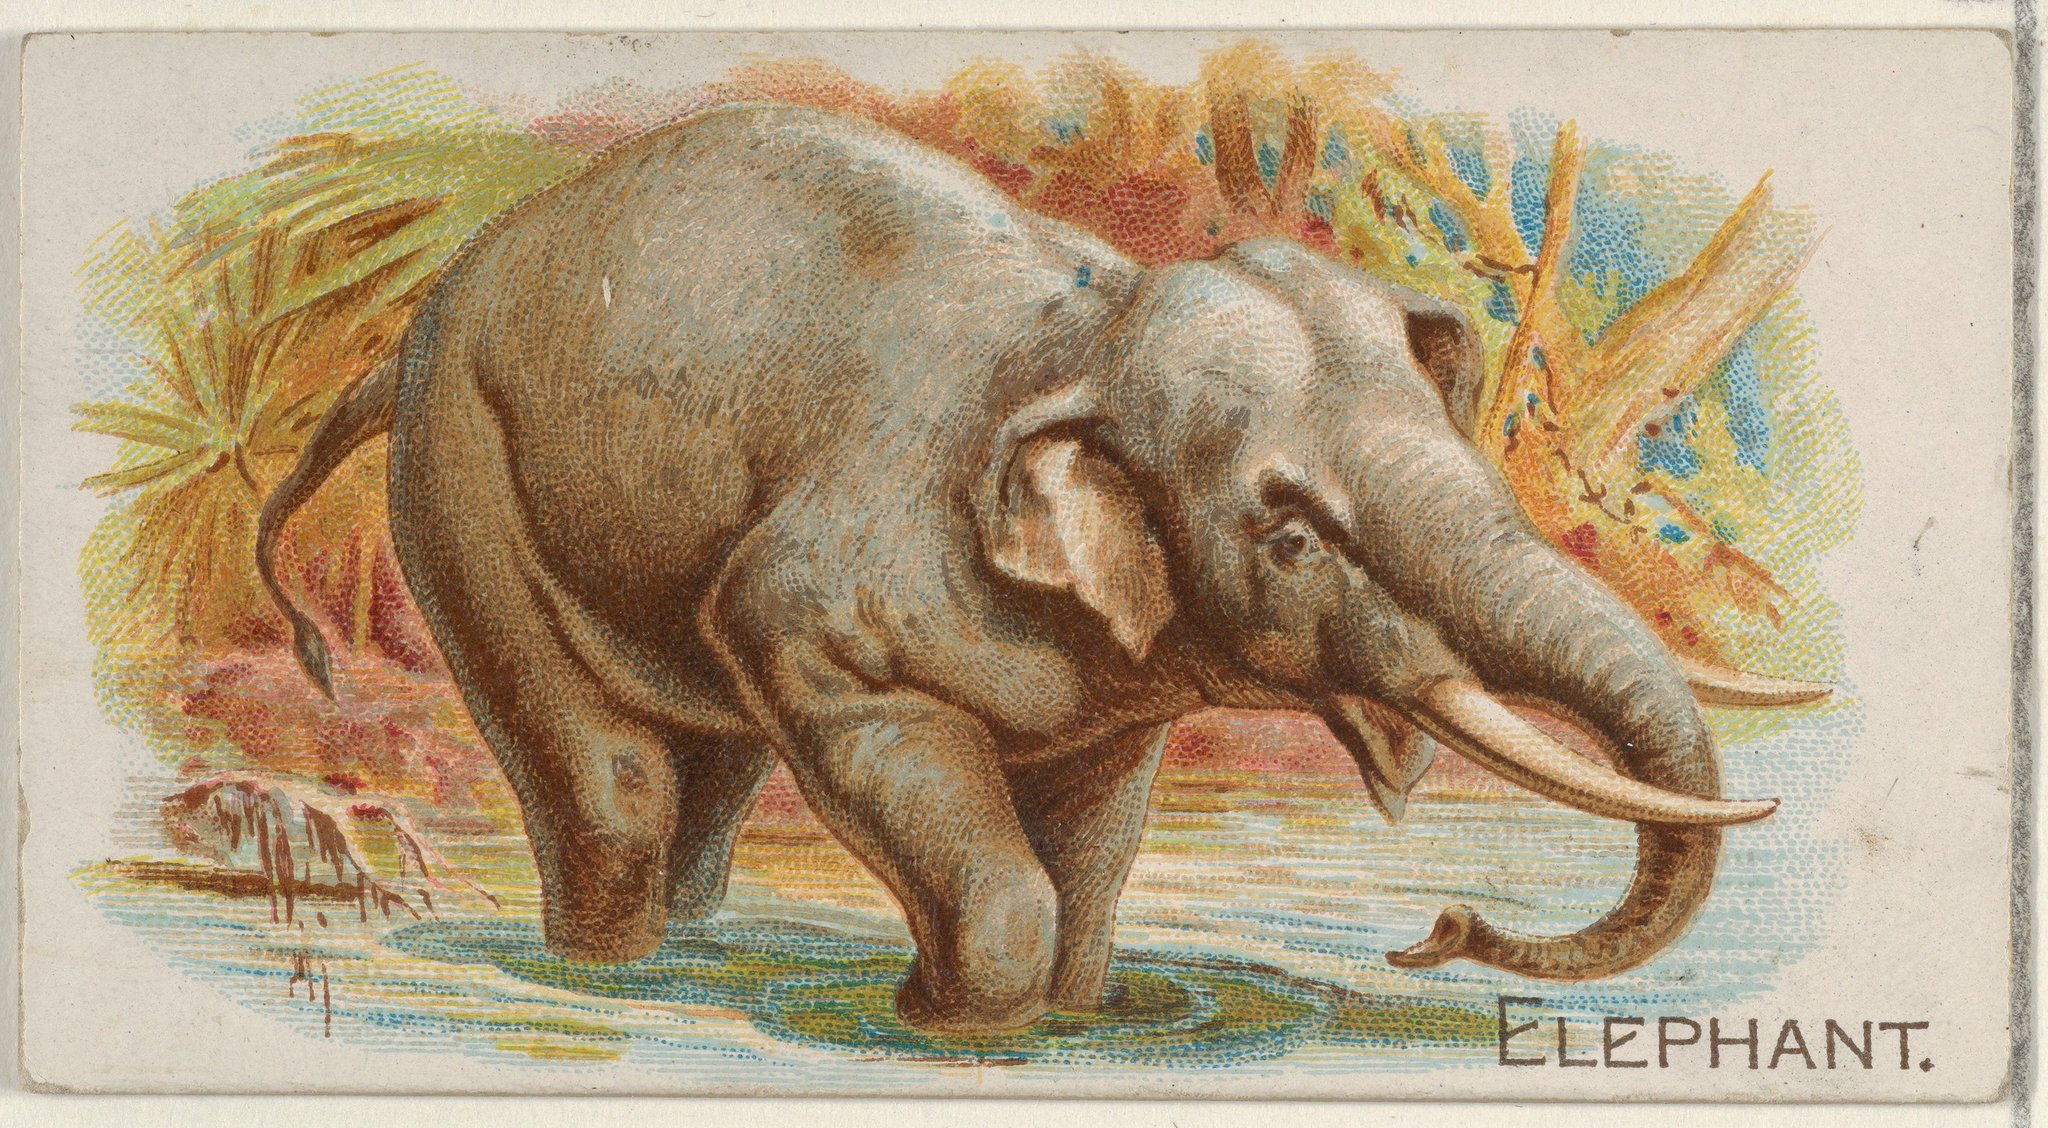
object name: print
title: Elephant, from the Quadrupeds series (N21) for Allen & Ginter Cigarettes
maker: allen & ginter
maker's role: publisher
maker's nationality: american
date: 1890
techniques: color lithograph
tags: elephants